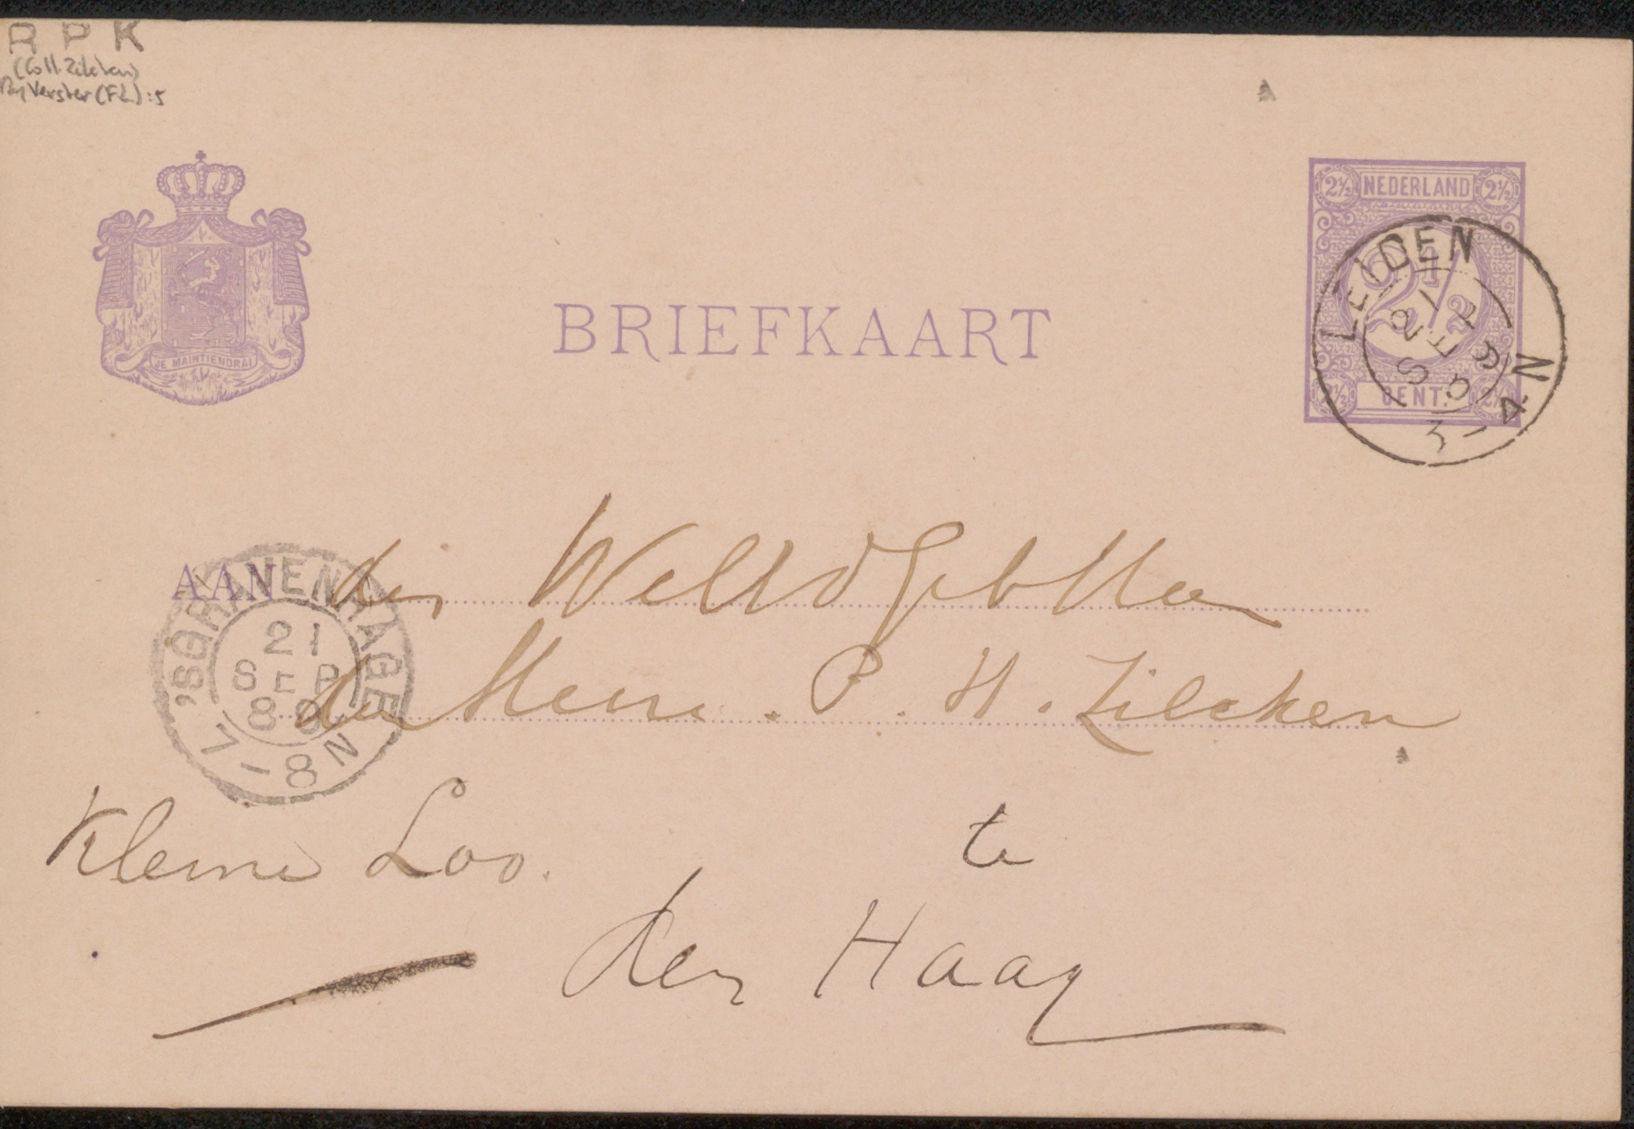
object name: postcard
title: Briefkaart aan Philip Zilcken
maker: floris verster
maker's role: draughtsman, painter, print maker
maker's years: 1861-1927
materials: cardboard, ink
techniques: pen, writing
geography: leiden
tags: james abbott mcneill whistler, the hague, painter, draughtsman, philip zilcken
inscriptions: collector's mark: ‘RPK’